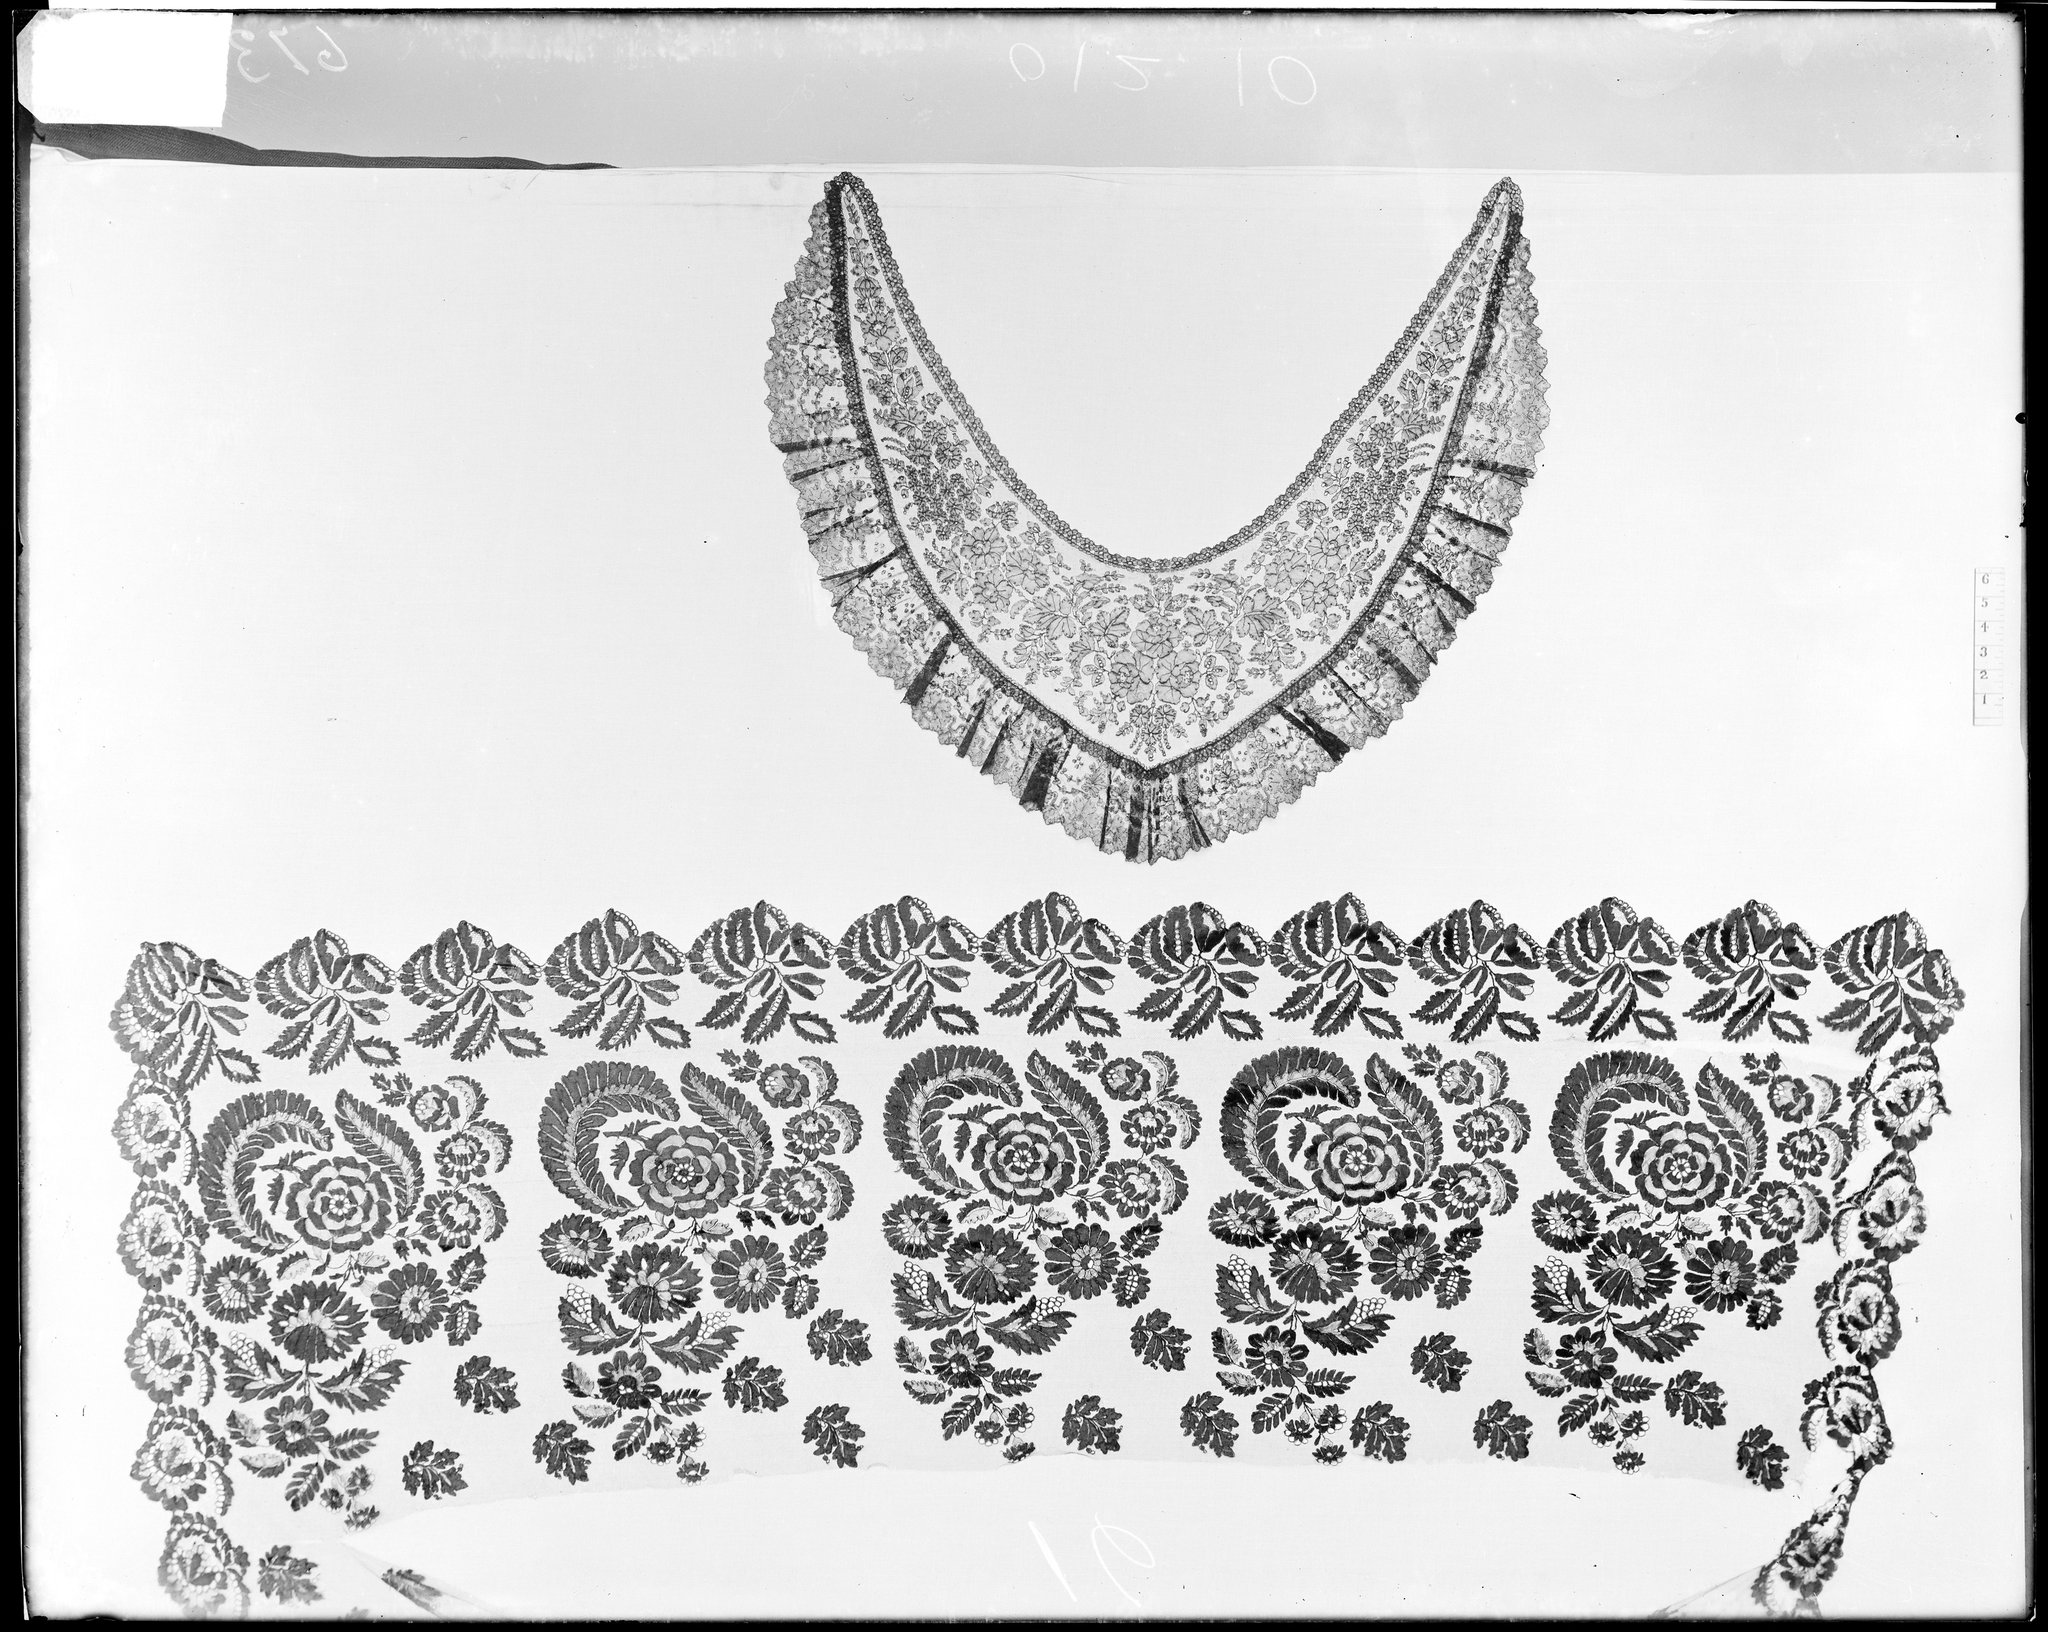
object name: fichu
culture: french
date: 1801-1900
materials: silk